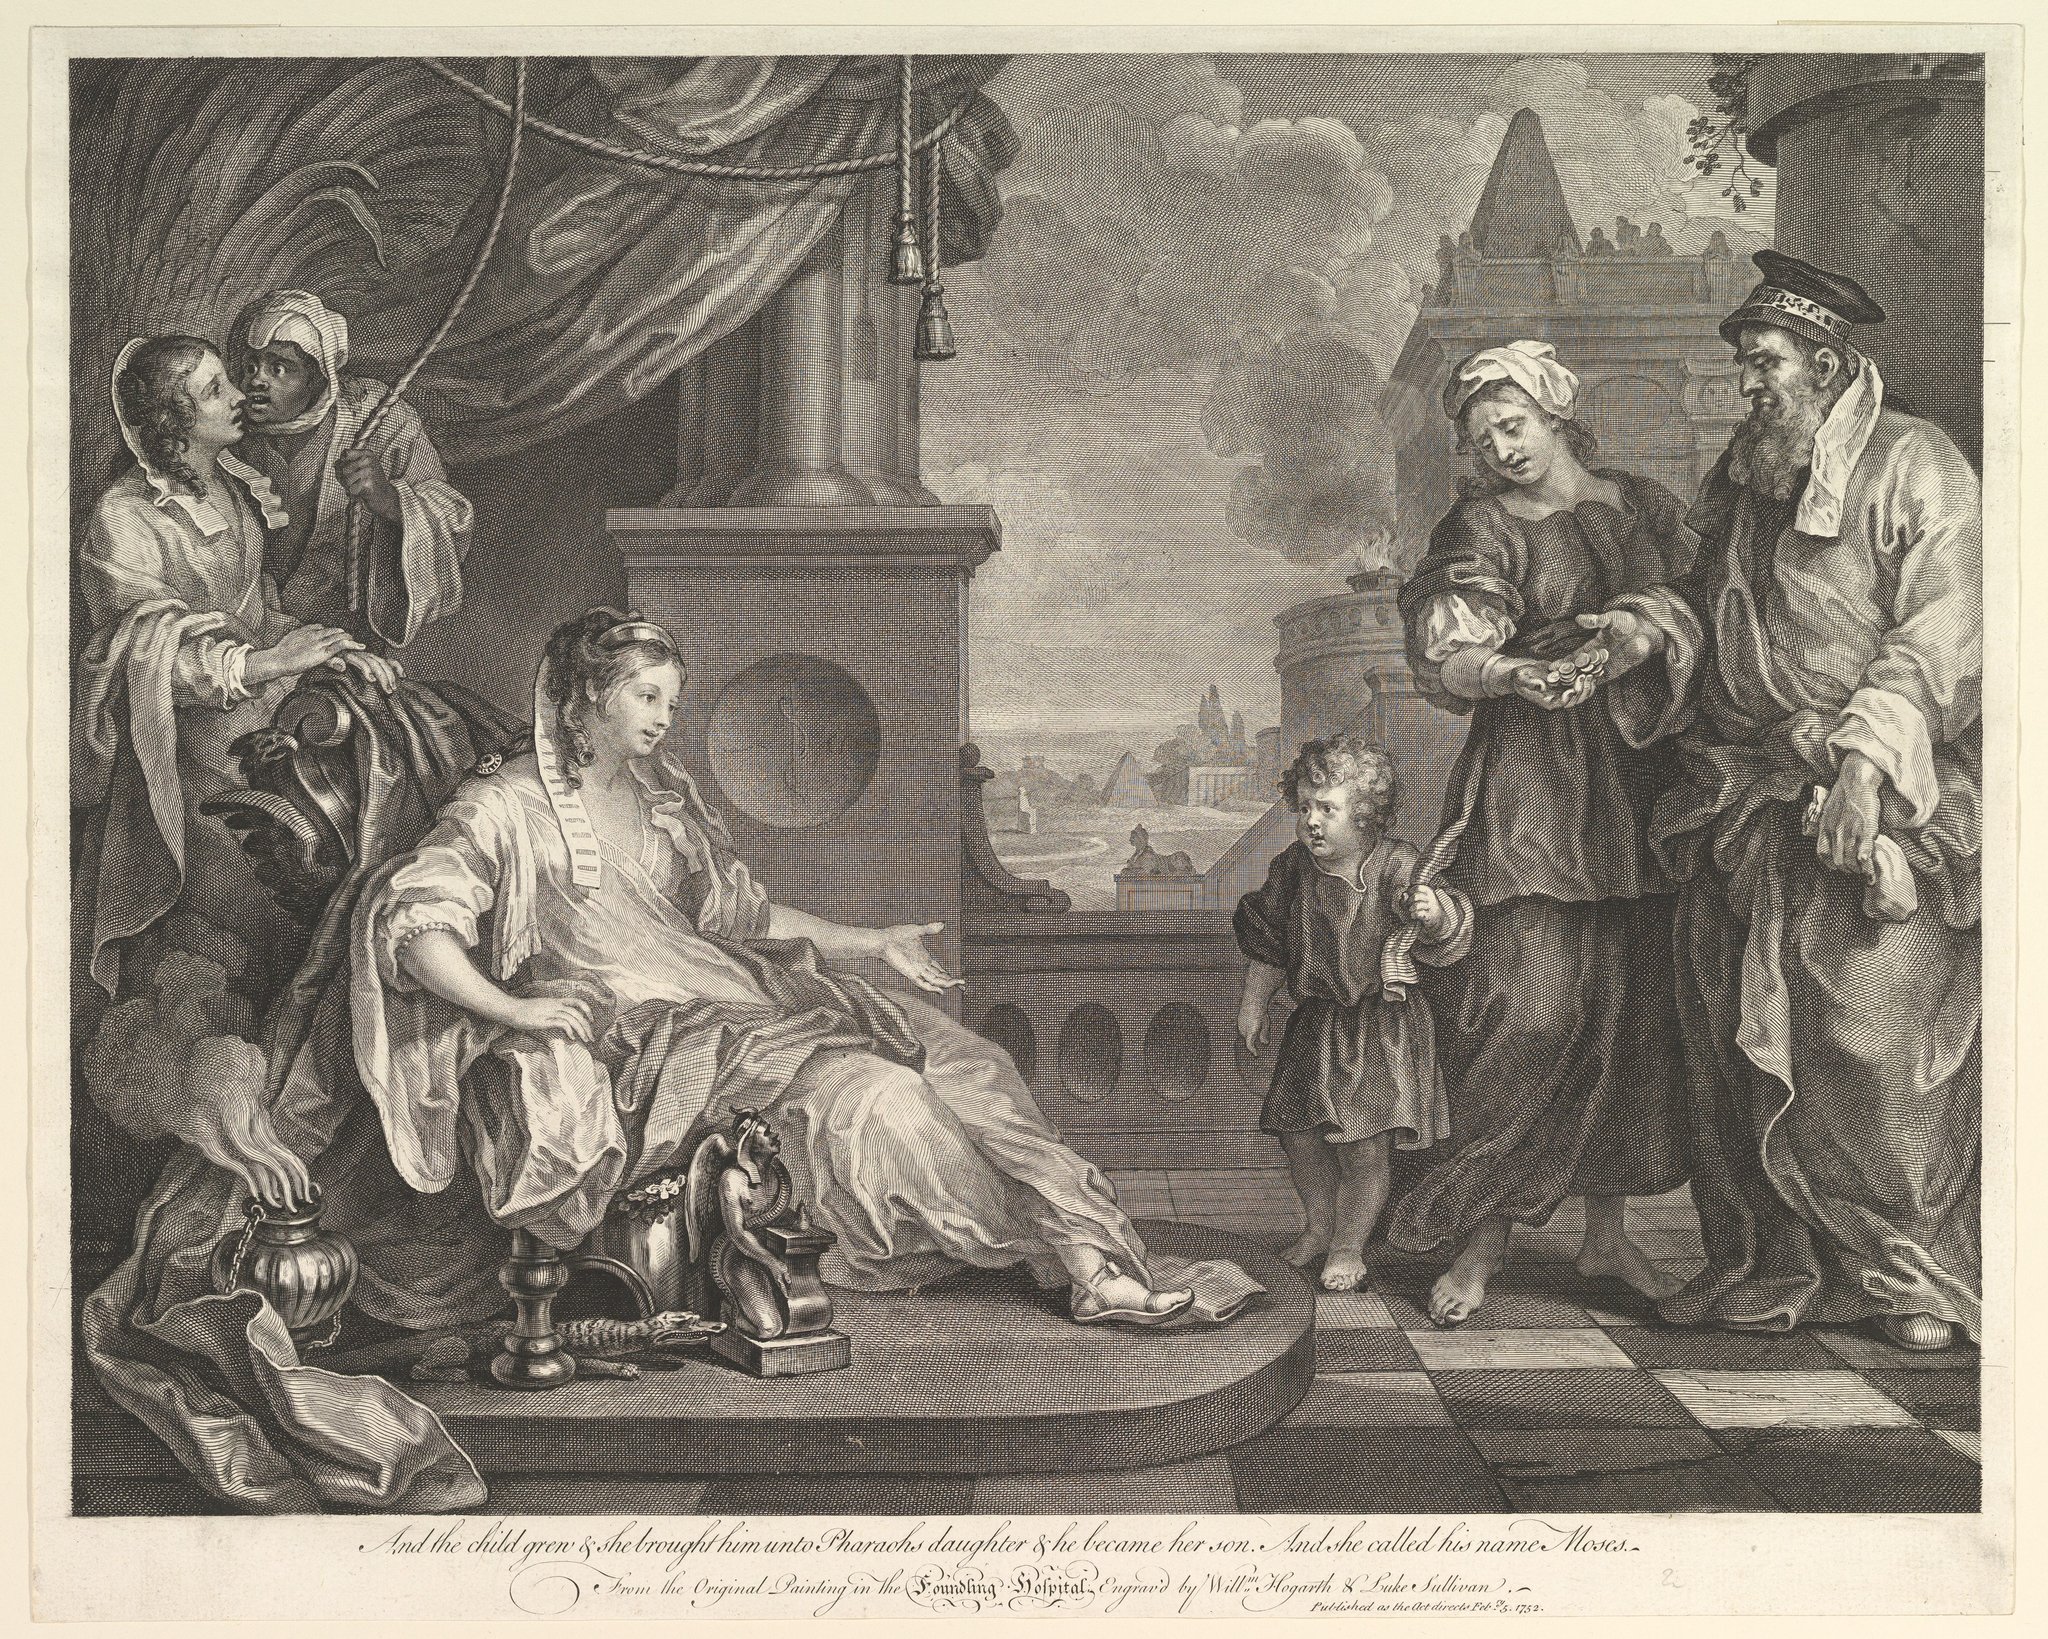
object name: print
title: Moses Brought to Pharaoh's Daughter (Exodus 2:10)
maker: william hogarth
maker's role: artist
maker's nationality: british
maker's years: 1697-1764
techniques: engraving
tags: children,men,women,crocodiles,moses